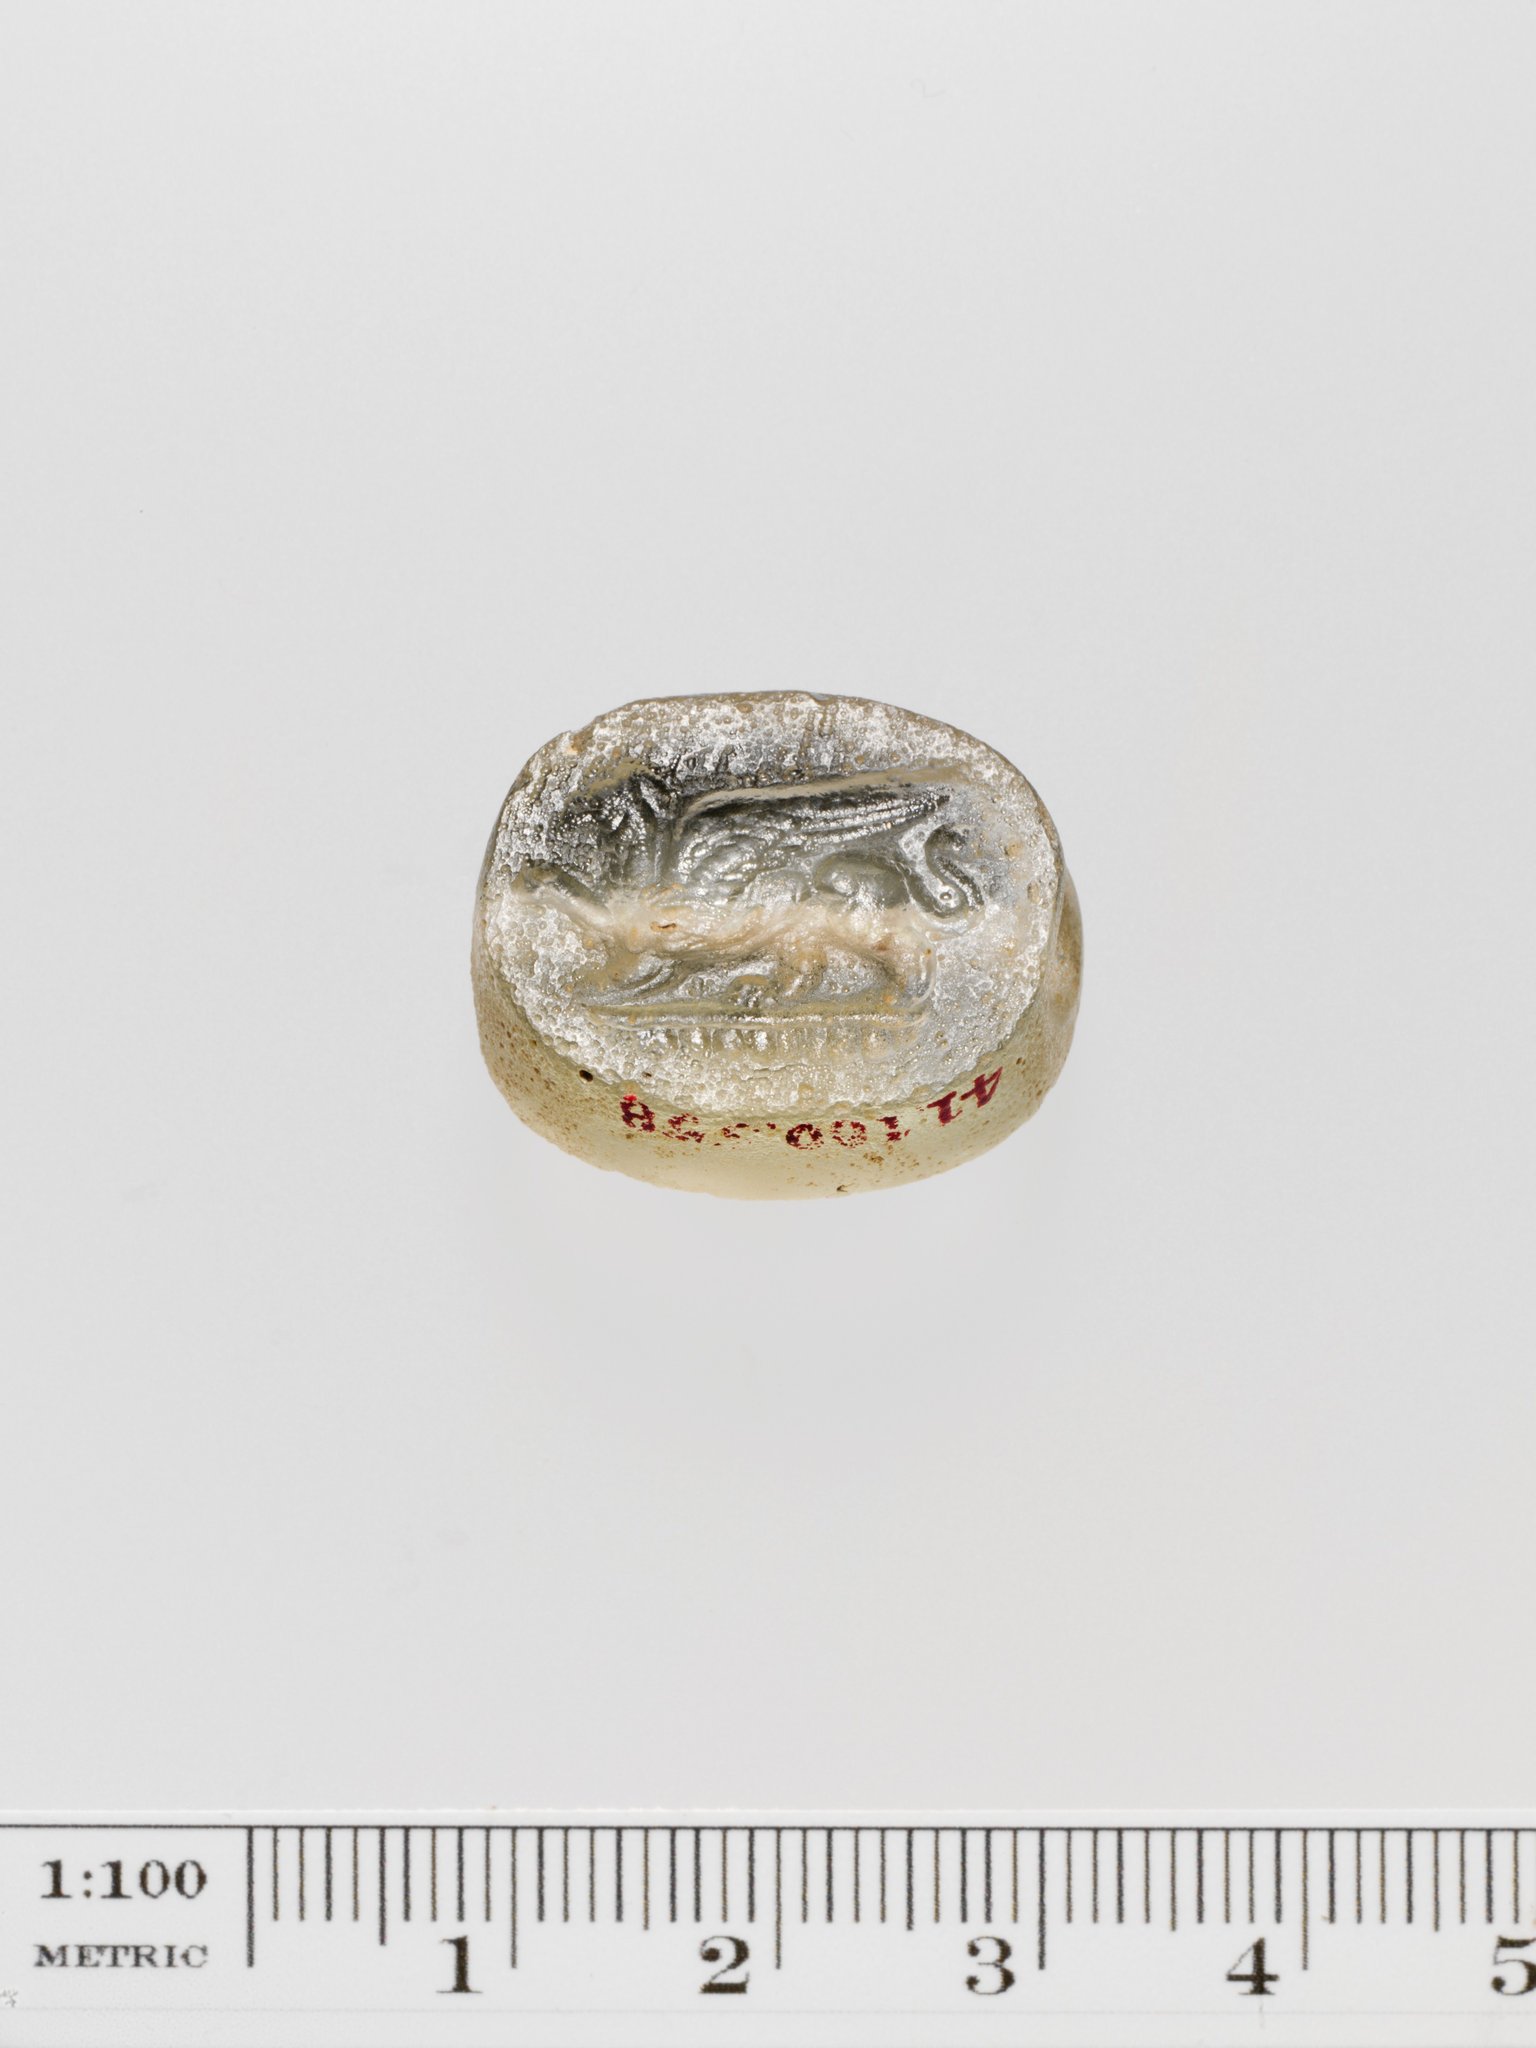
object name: scaraboid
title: Transparent glass scaraboid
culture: greek, ionian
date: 450-400 BCE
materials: glass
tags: griffins